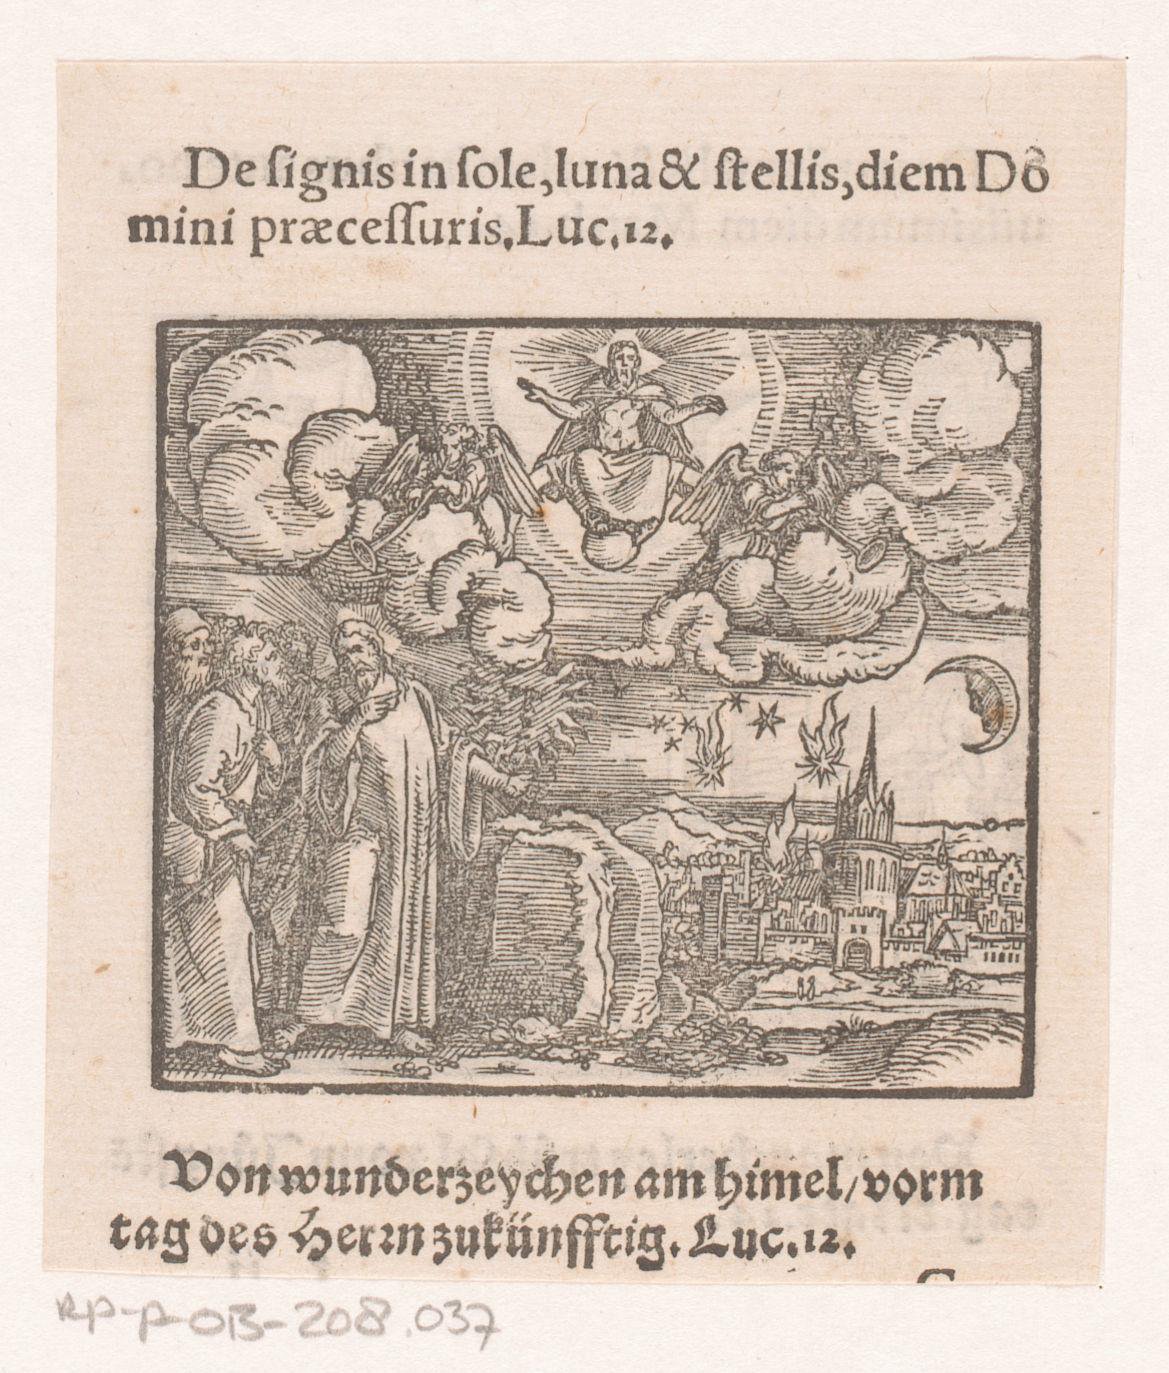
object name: print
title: Verbreken van het zesde zegel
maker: Anonymous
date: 1600-1699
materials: paper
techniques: letterpress printing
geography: netherlands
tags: opening of the sixth seal: a great earthquake, the sun turns black, the moon red as blood, and the stars fall on earth; mankind hiding in caves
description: Aardbevingen en overstromingen teisteren de wereld. De maan en de zon staan hoog aan de hemel en brandende sterren vallen uit de hemel op aarde.